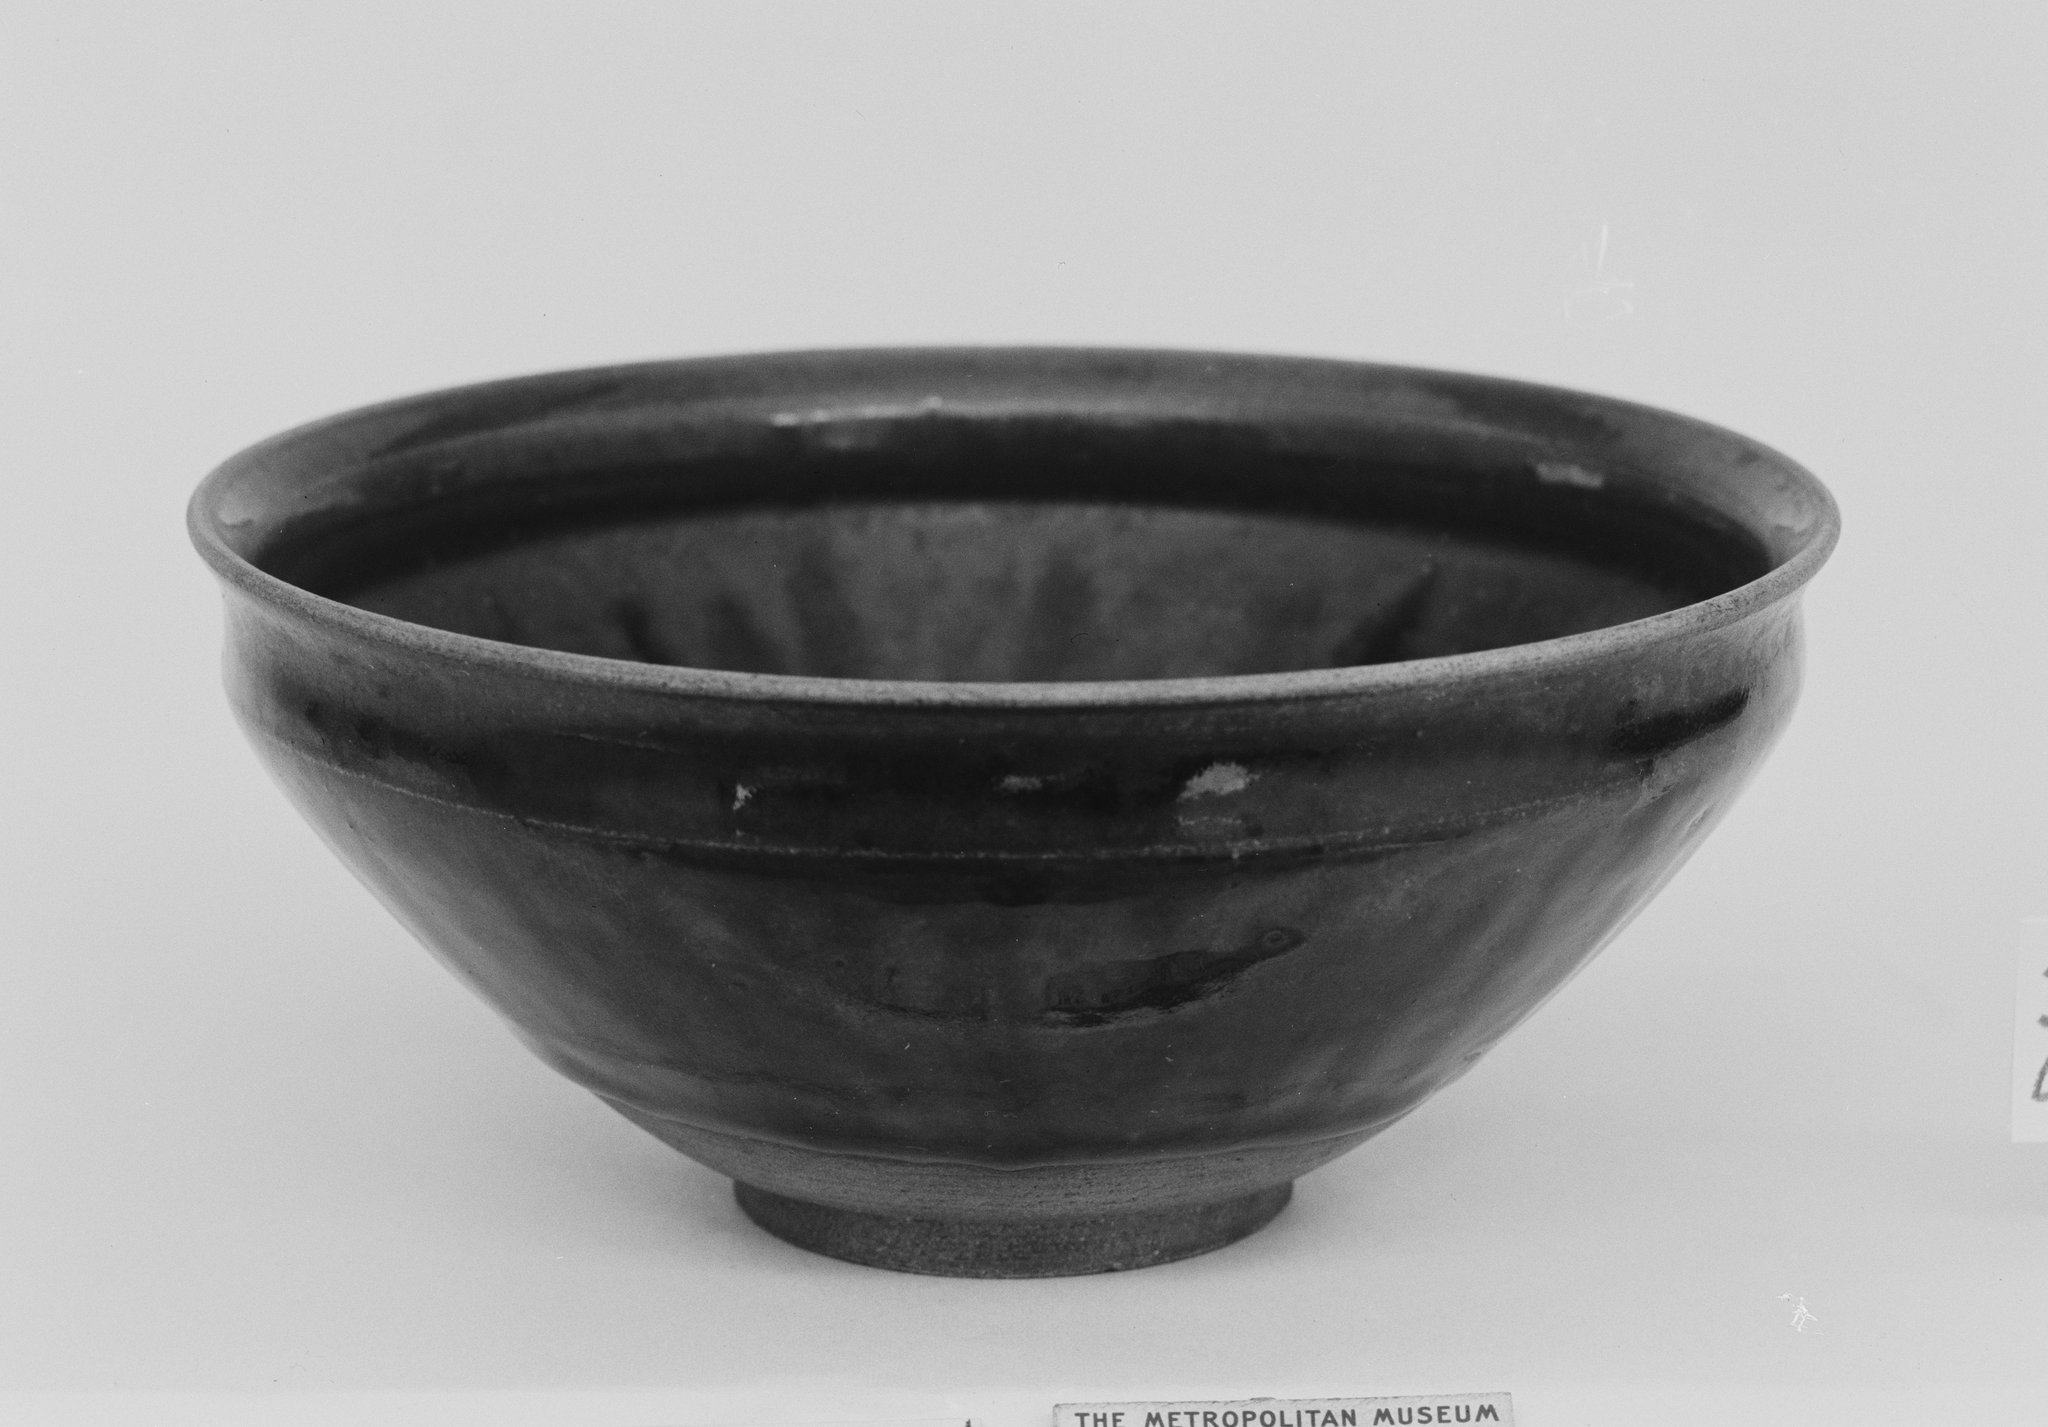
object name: bowl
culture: japanese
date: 1701-1800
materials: glaze, paste